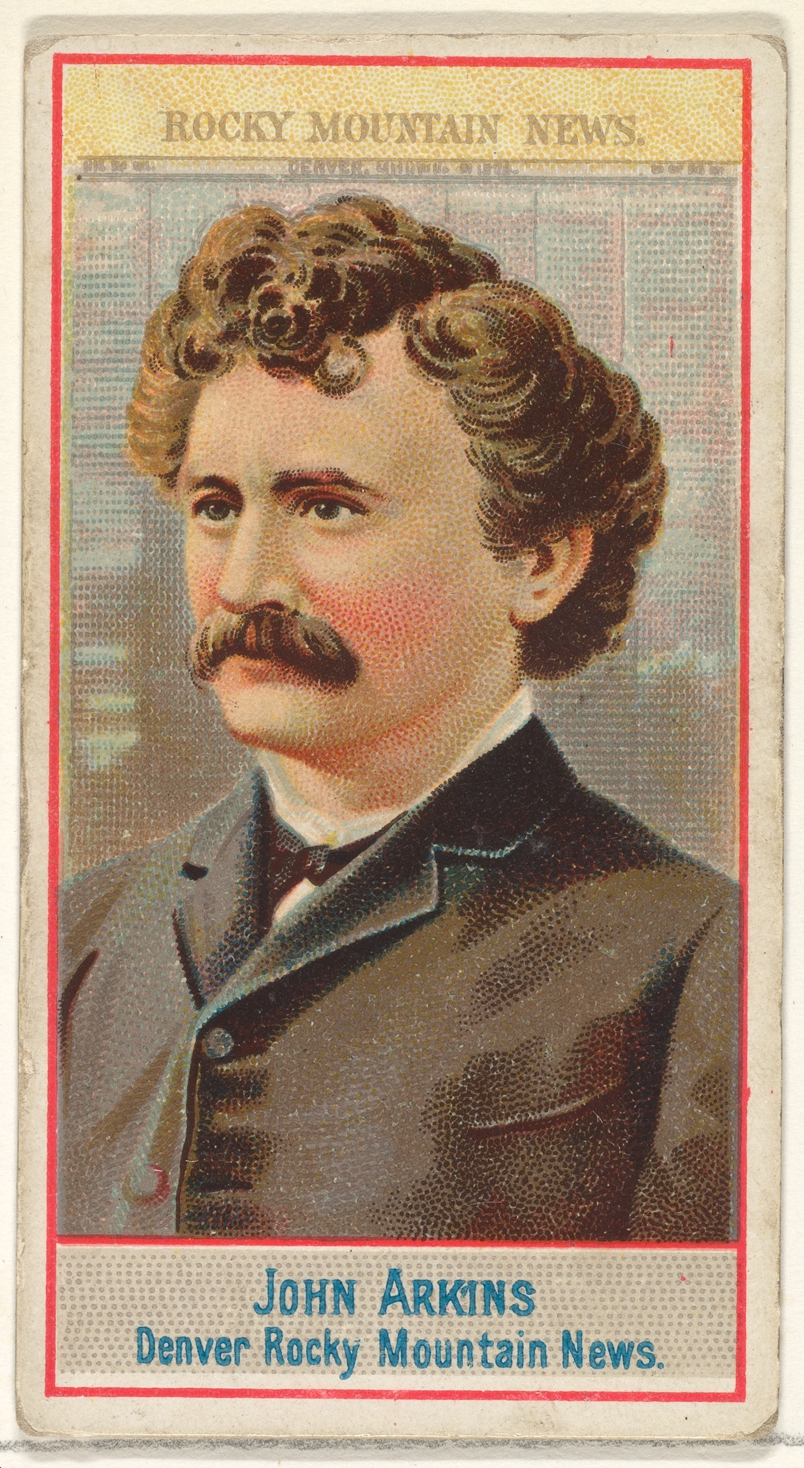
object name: print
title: John Arkins, Denver Rocky Mountain News, from the American Editors series (N1) for Allen & Ginter Cigarettes Brands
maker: allen & ginter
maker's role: publisher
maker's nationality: american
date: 1887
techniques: color lithograph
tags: men,portraits